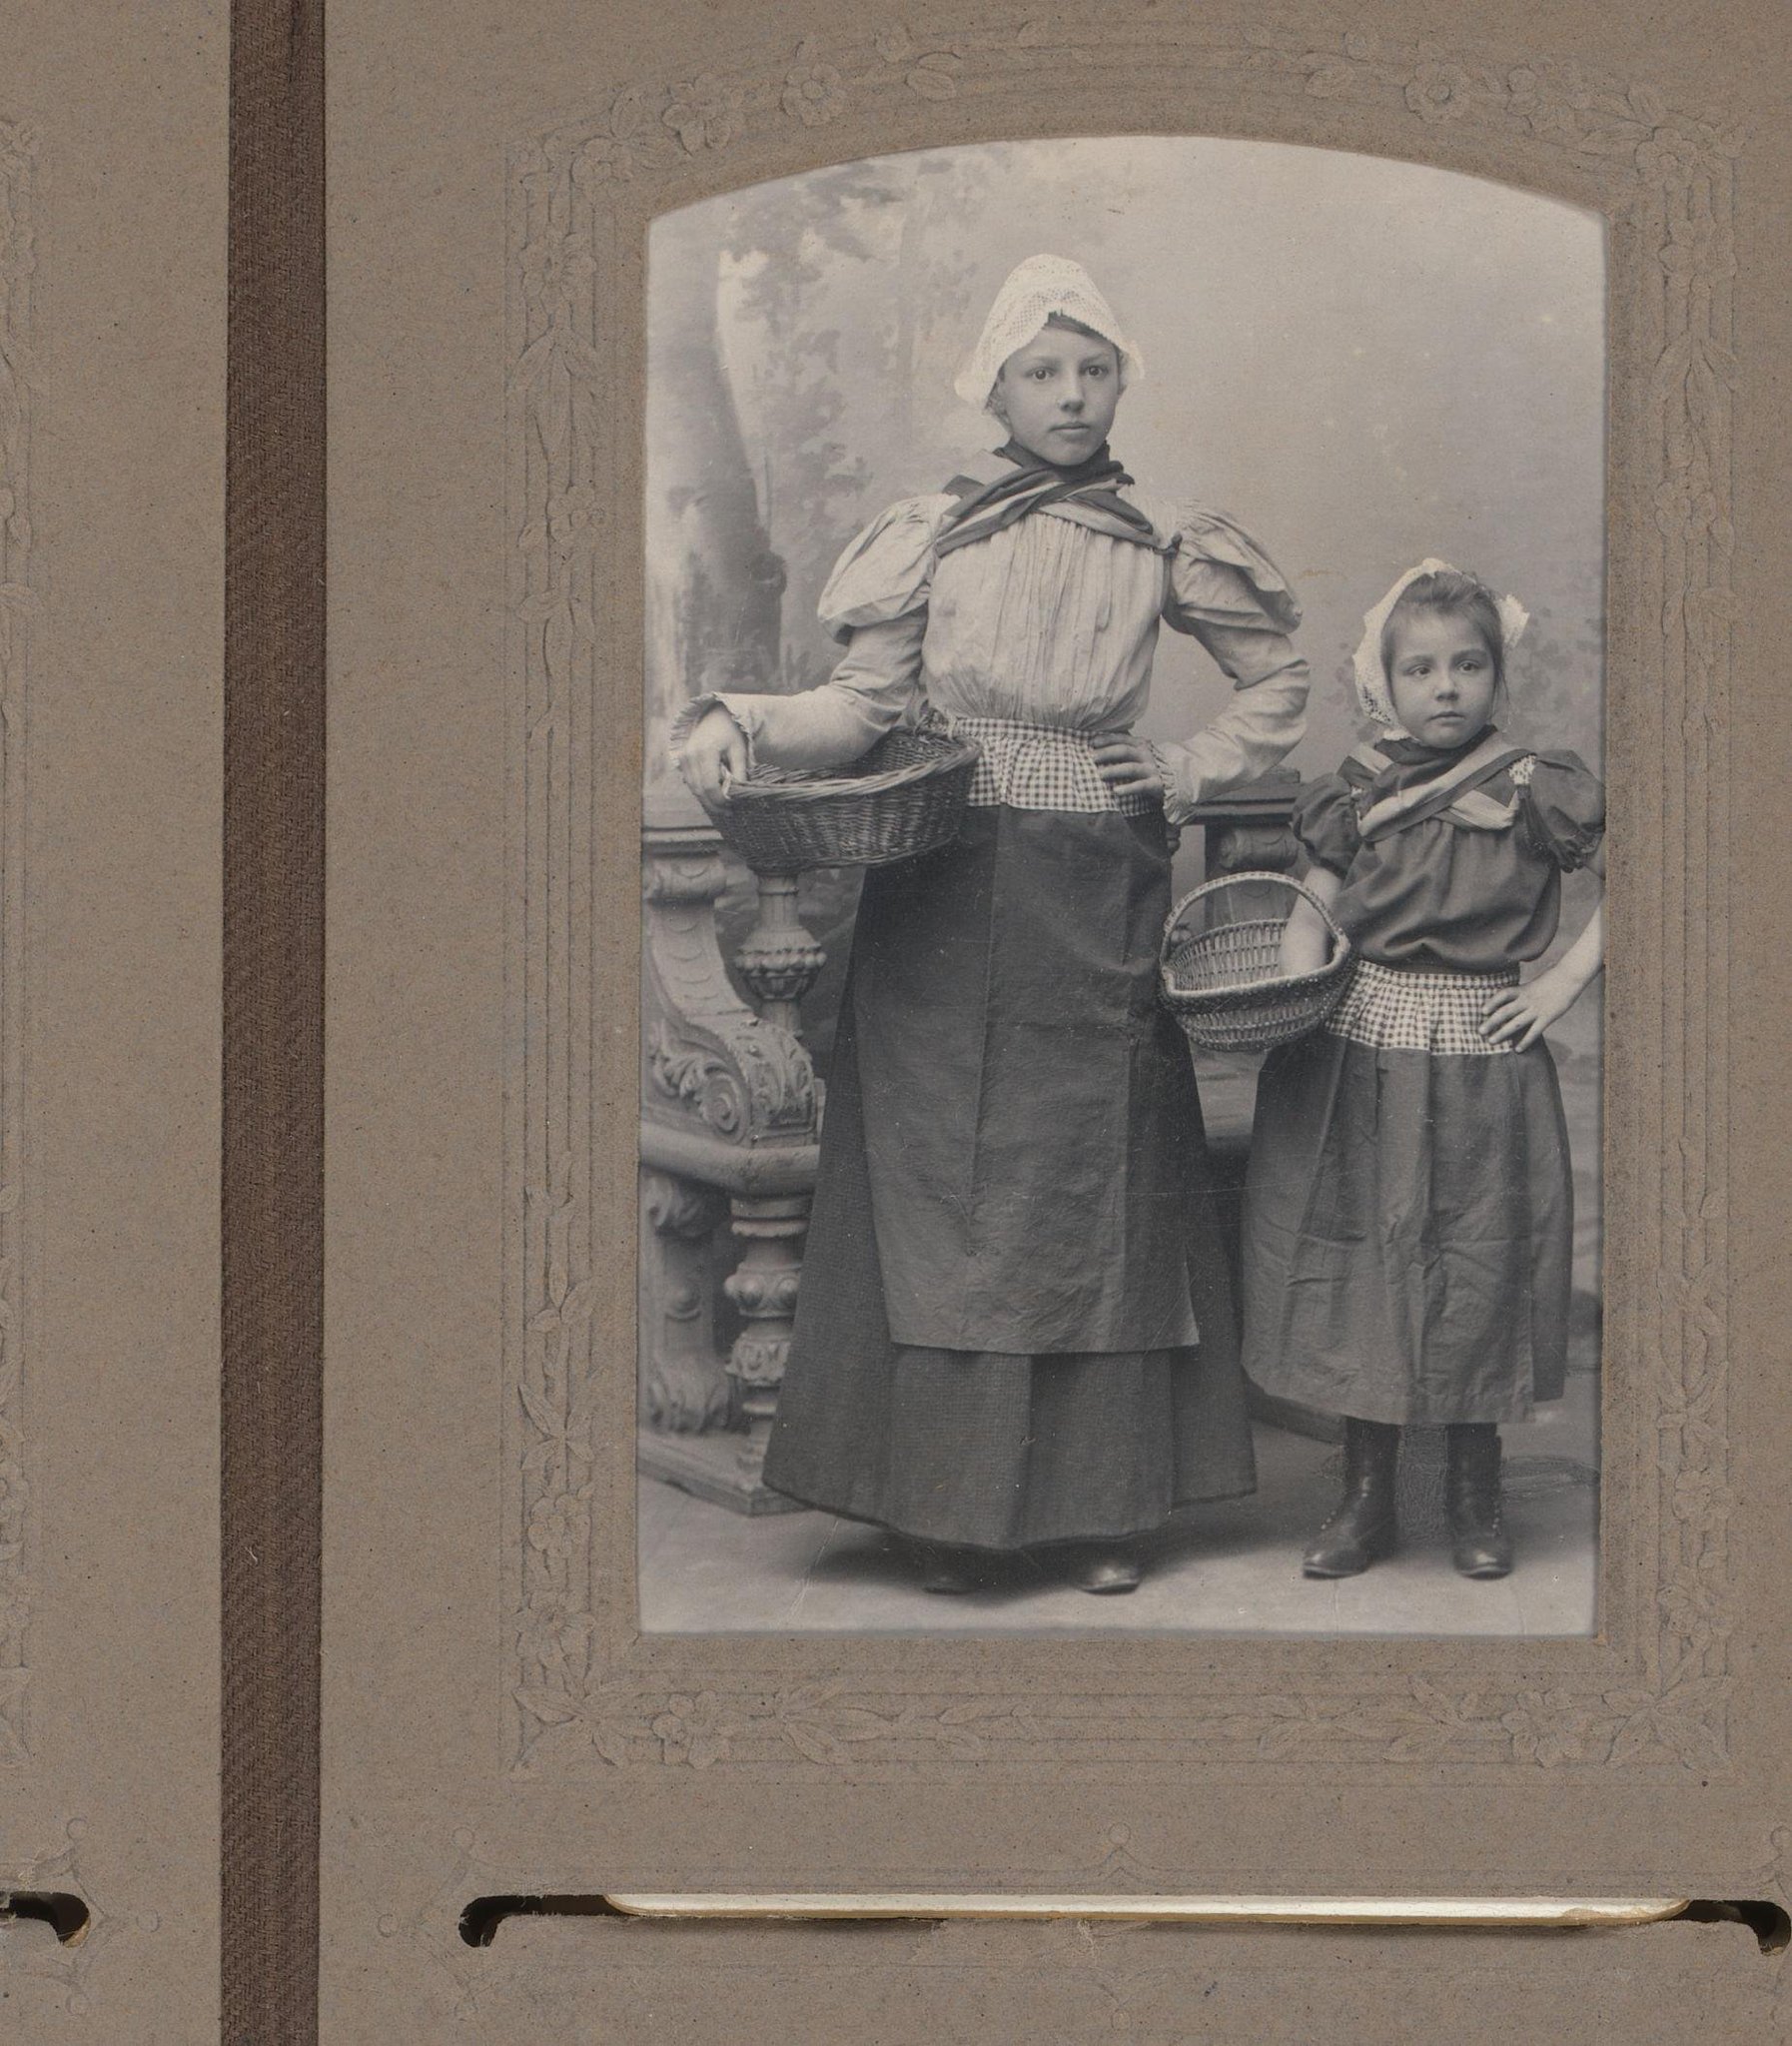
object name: photograph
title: Portret van twee kinderen in Nederlandse klederdracht met manden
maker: johan herman van der laag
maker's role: fotograaf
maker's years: 1865-1937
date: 1895-1920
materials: cardboard, photographic support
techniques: matte daylight collodion silver print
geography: wageningen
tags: historical persons - bb - woman, container made of plant material other than wood: basket, folk costume, regional costume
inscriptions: inscription: ‘PHOTOGRAPHIE/ J. H. van der Laag/ DE PLATEN BLIJVEN VOOR/ NABESTELLING BEWAARD/ WAGENINGEN/ Prager & Lojda, Berlin./ 17399’